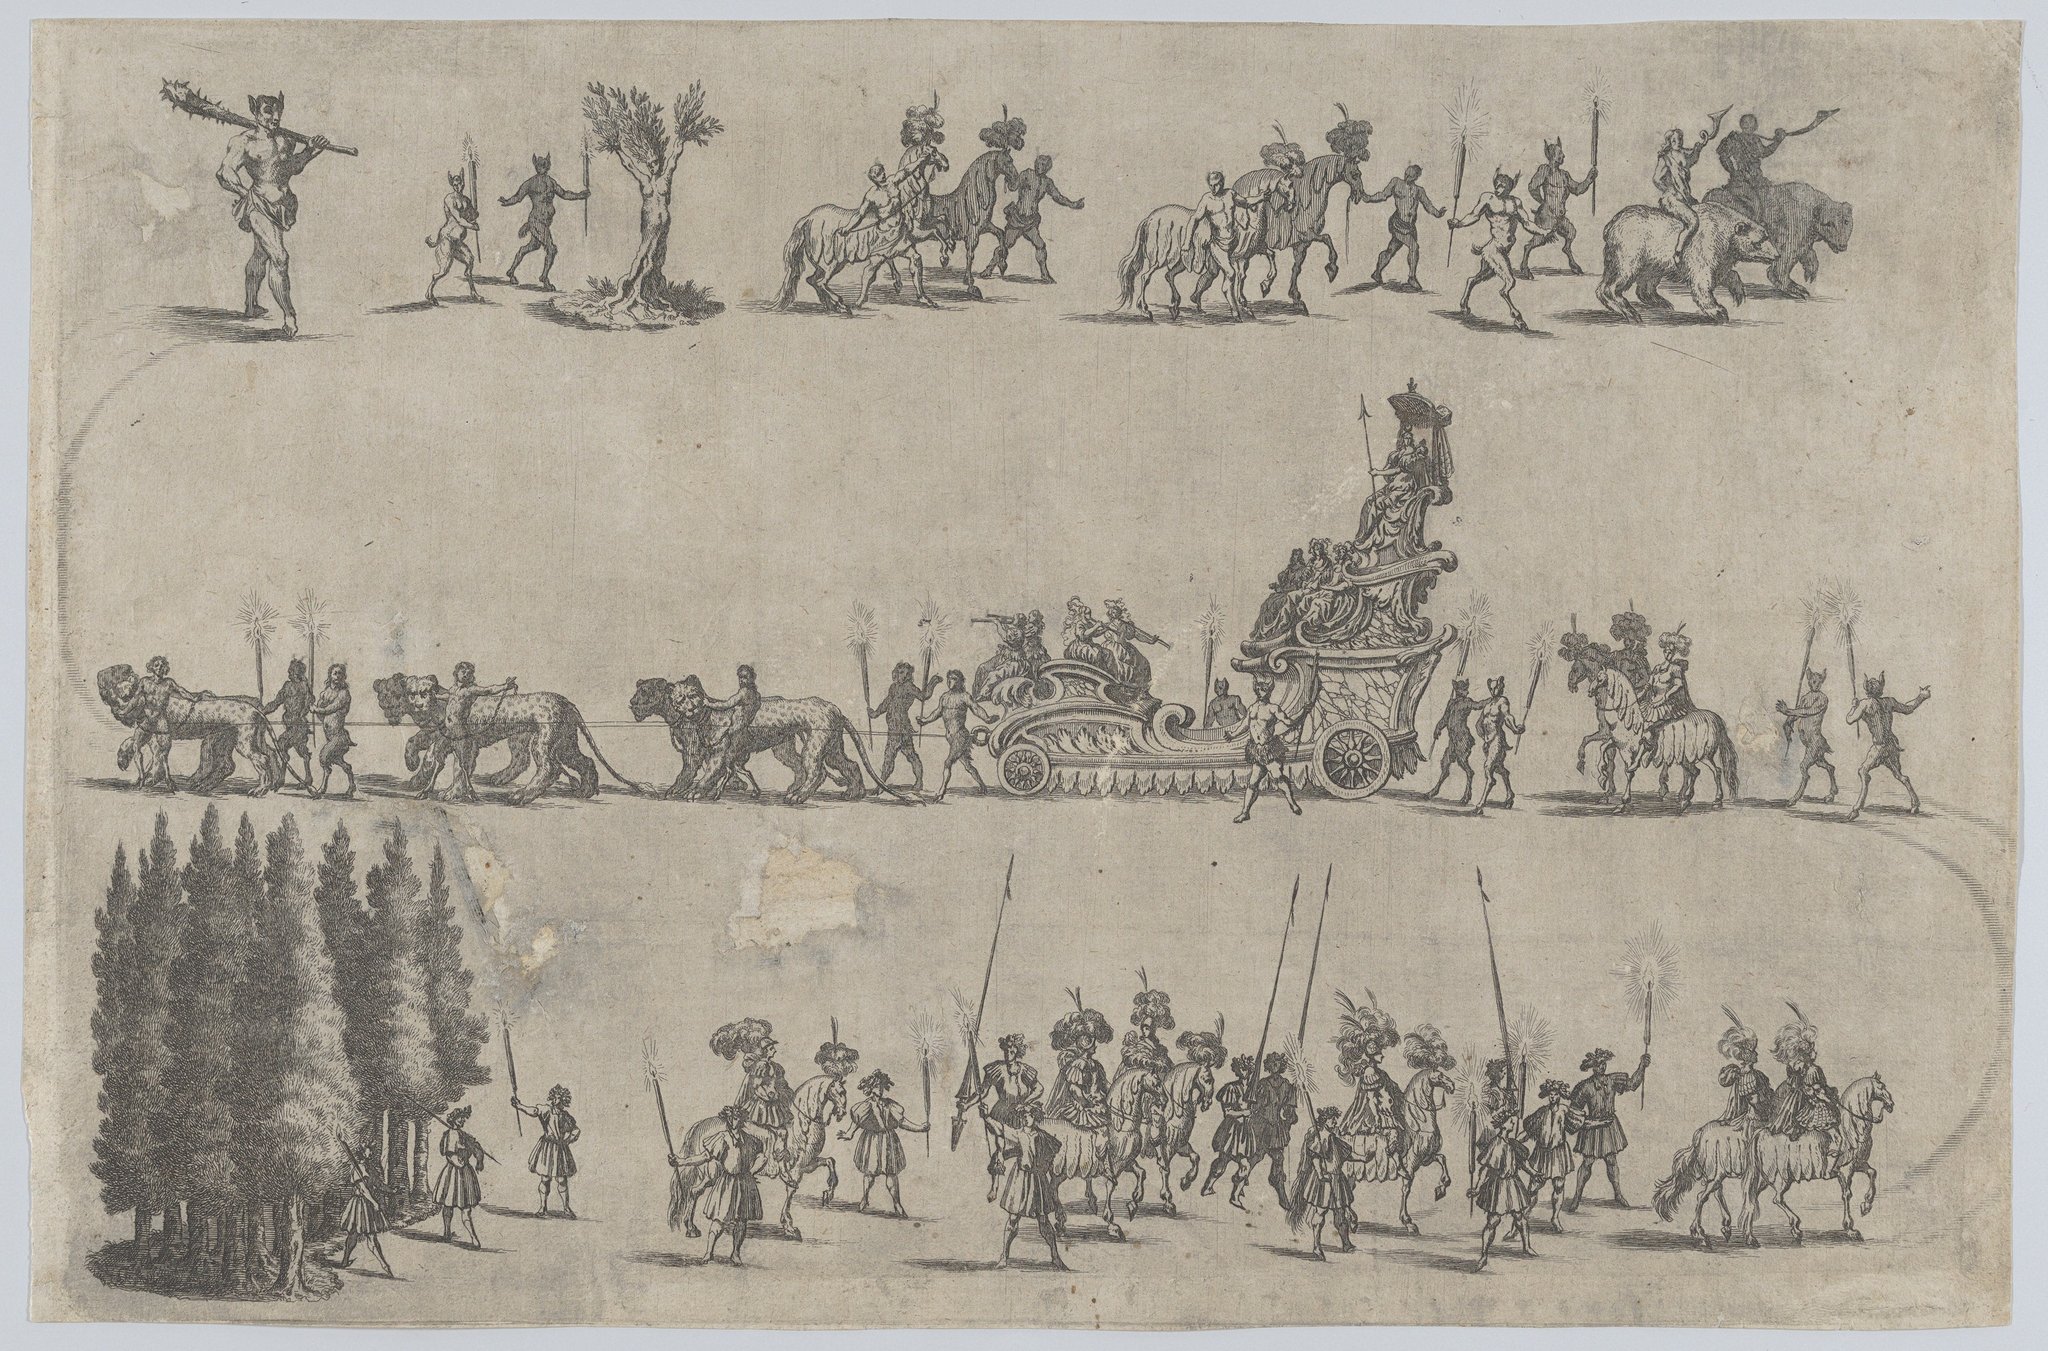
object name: print, fete, ornament architecture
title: Plate 7 from Pietro Paulo Bissari, Antiopa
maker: mathäus küsel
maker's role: artist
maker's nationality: german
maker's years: 1621-1682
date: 1662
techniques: etching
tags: animals,men,horses